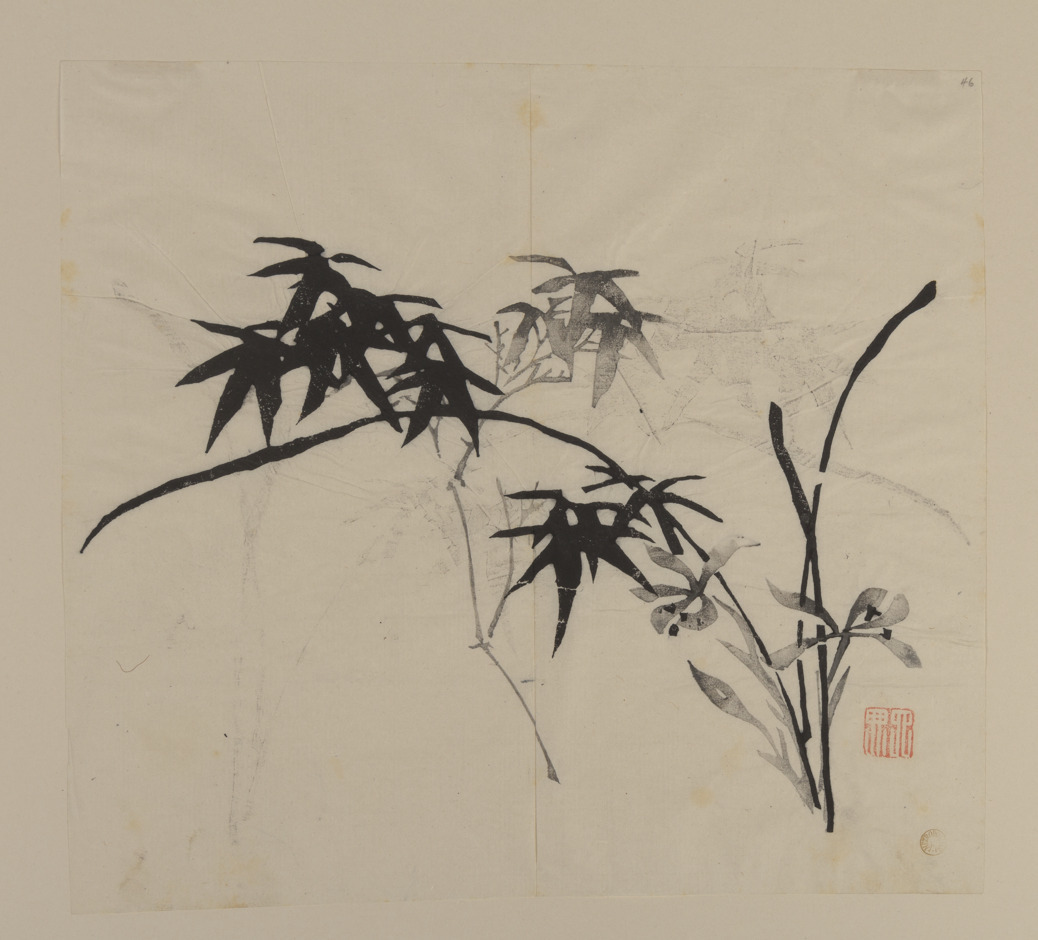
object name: print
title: Page from Shi Zhu Zhai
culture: chinese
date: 1736-1795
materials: ink, paper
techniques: polychrome, woodblock print